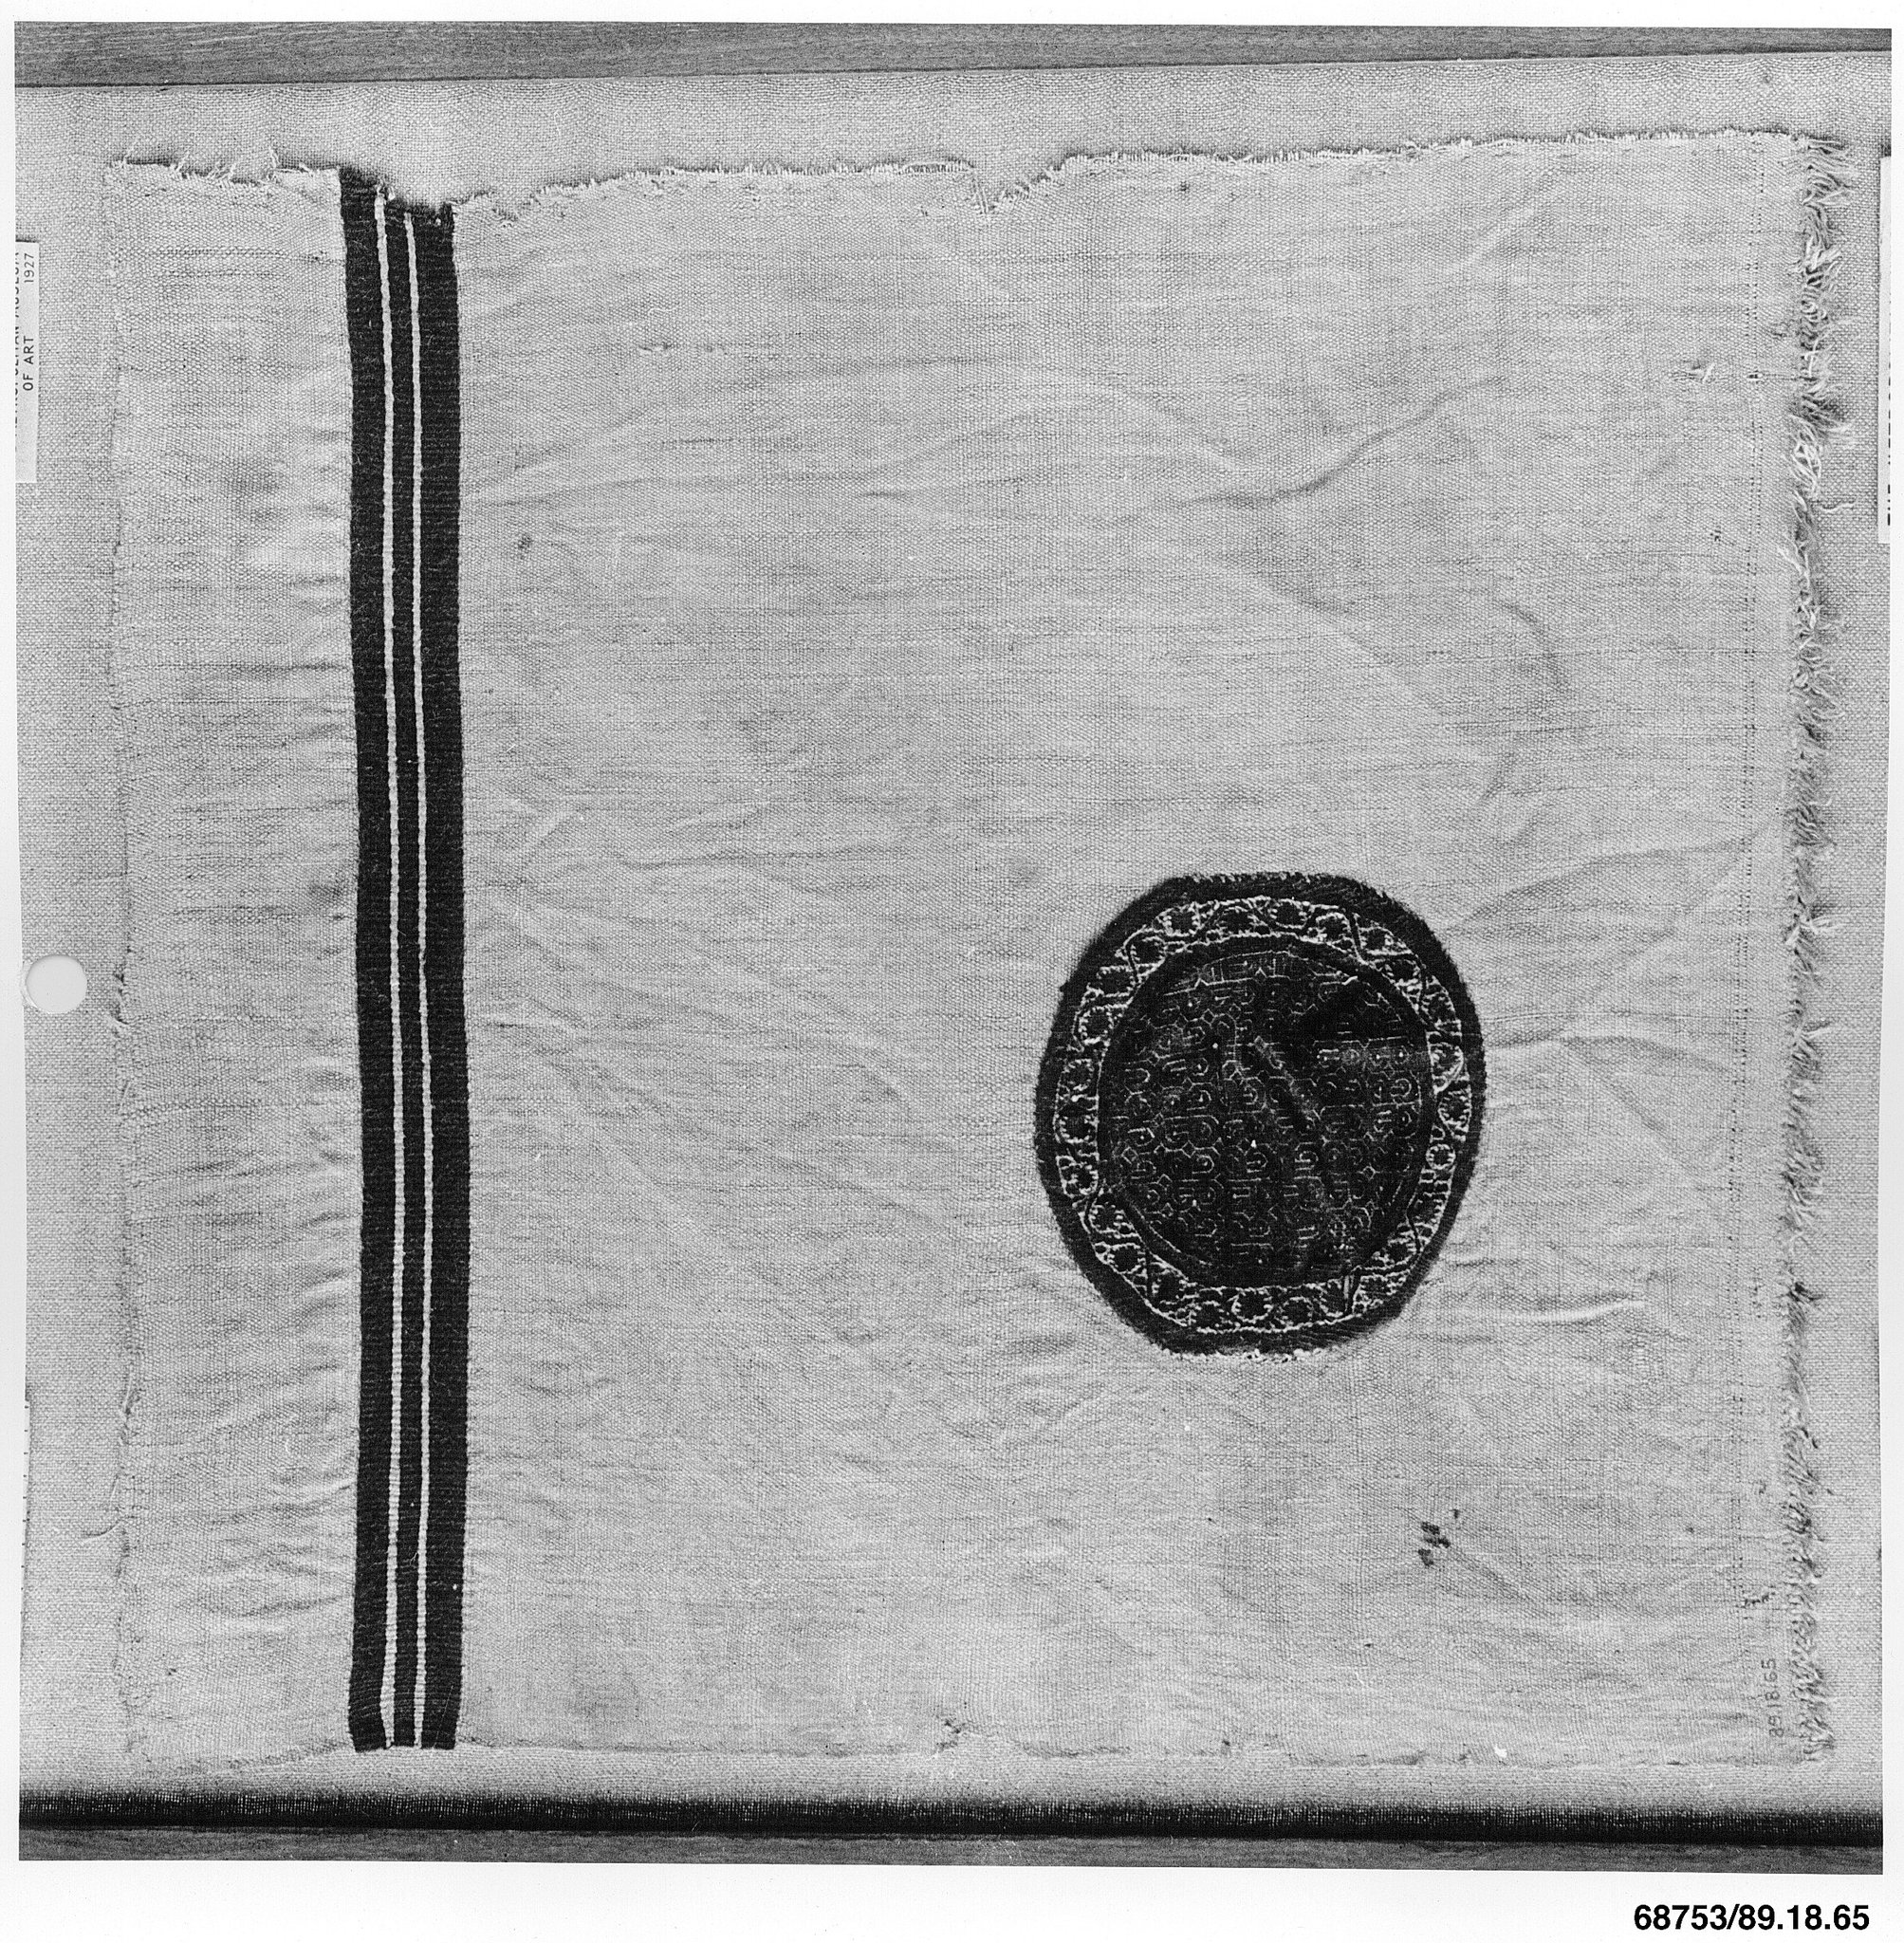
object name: textile fragment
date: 201-400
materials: linen, wool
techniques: weave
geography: egypt